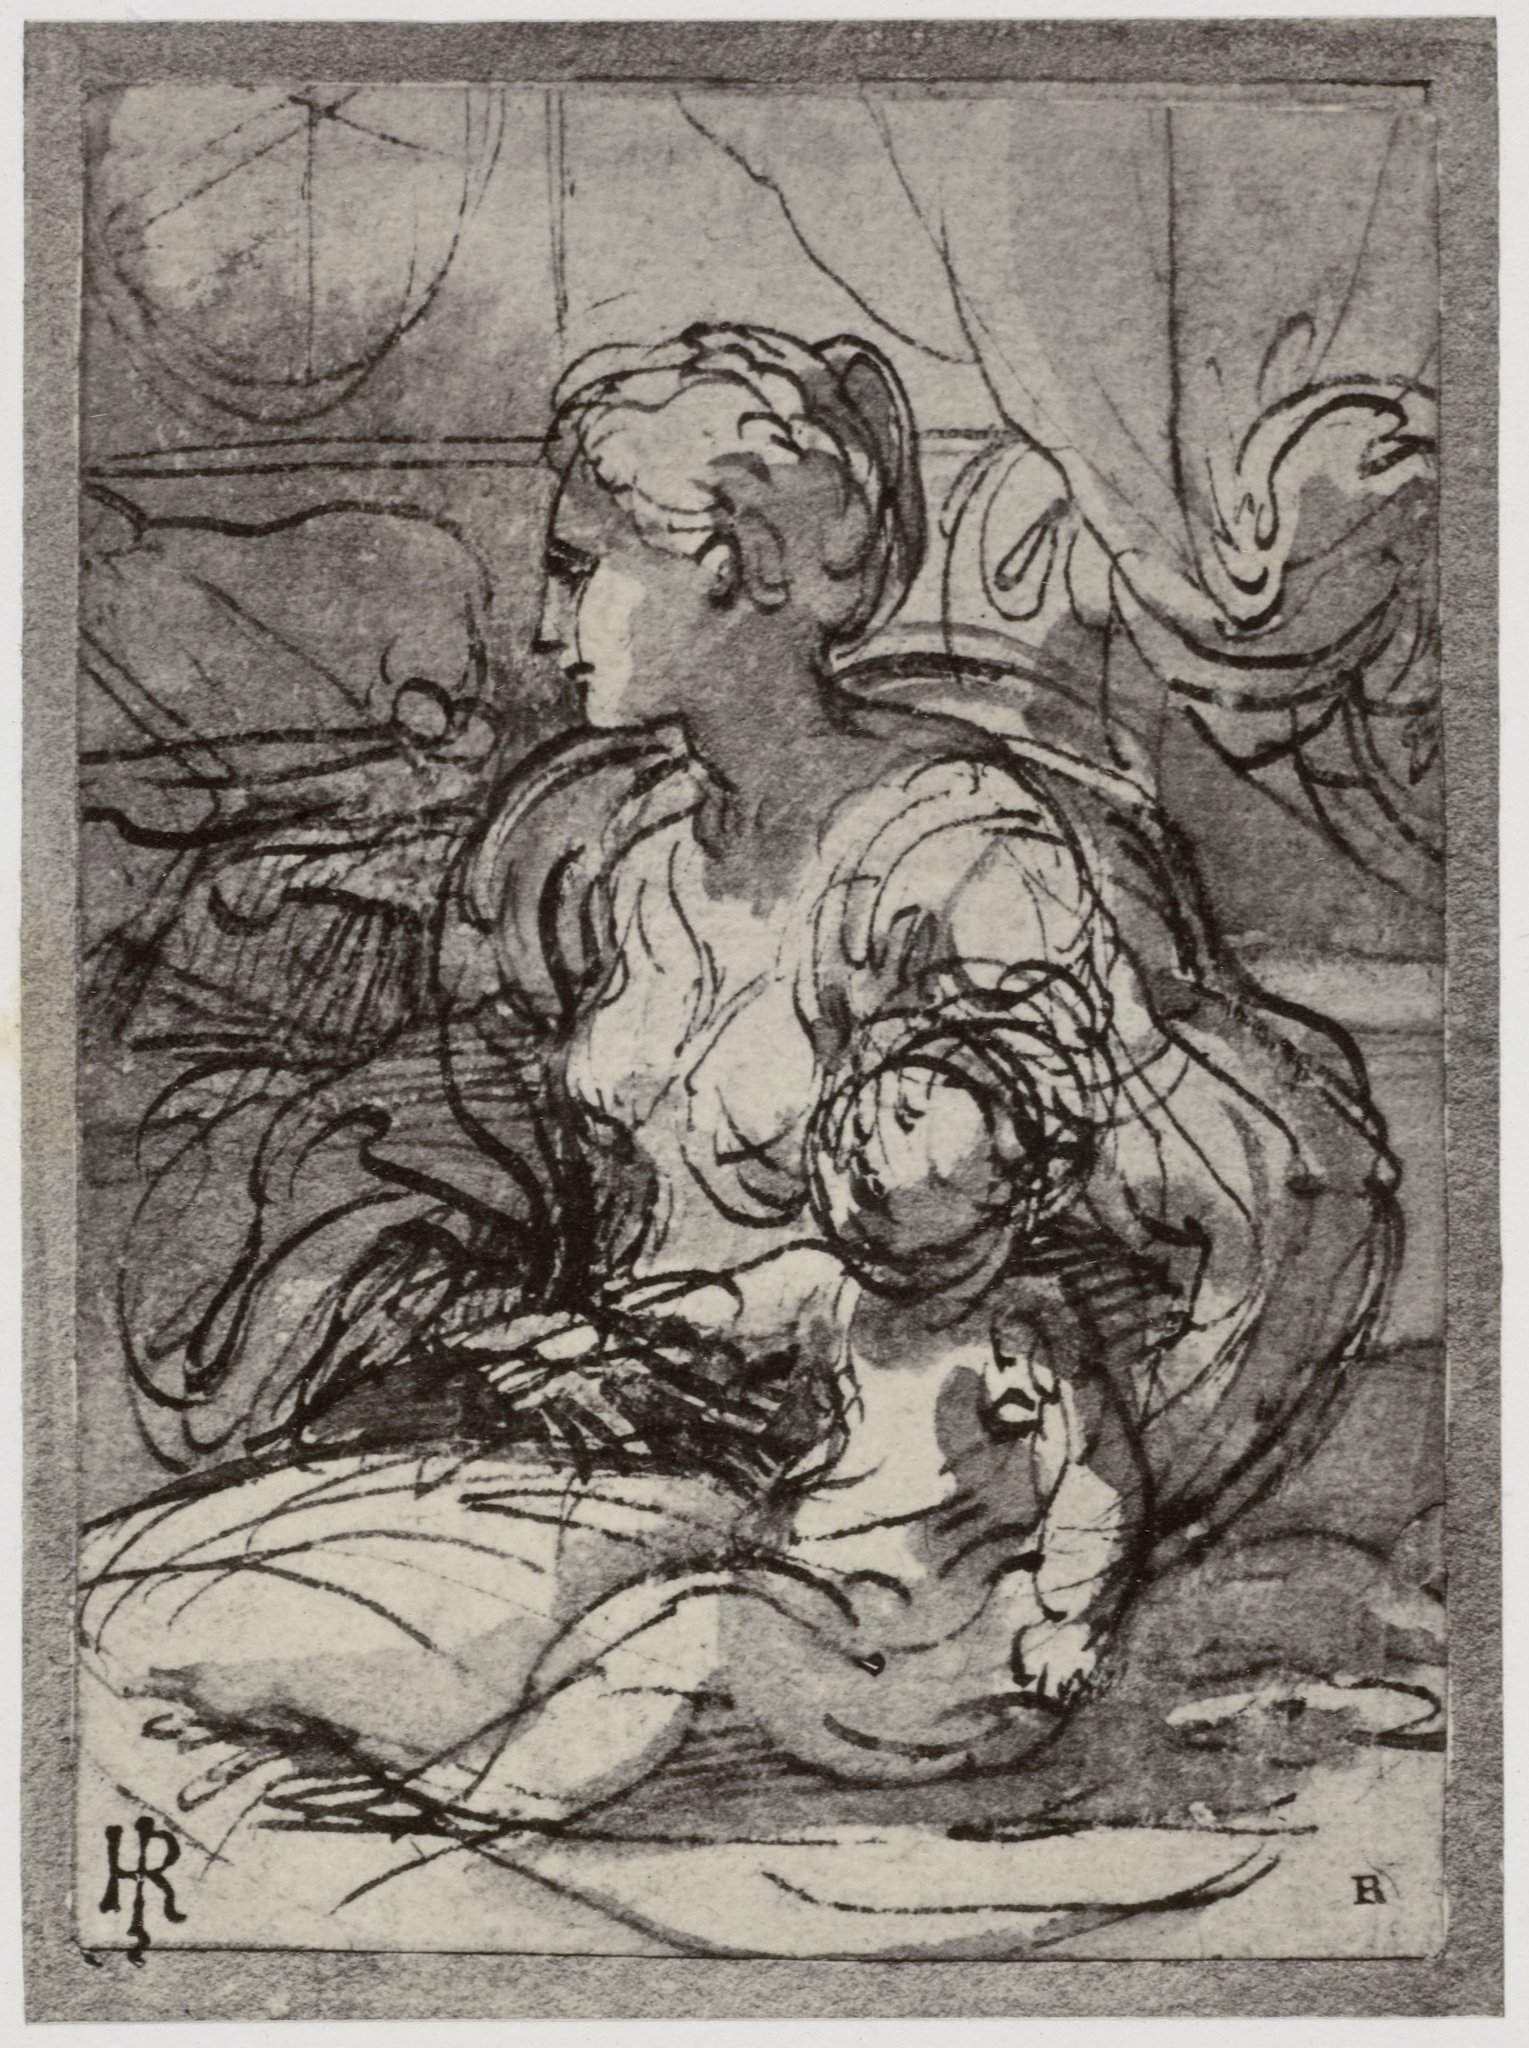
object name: photograph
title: Parmigianino, A Virgin and Child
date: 1855-1858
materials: cardboard, paper, photographic support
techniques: albumen print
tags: drawing, sketch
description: Fotoreproductie van tekening in 'The Reveley Collection of Drawings at Brynygwin', afb. 26.